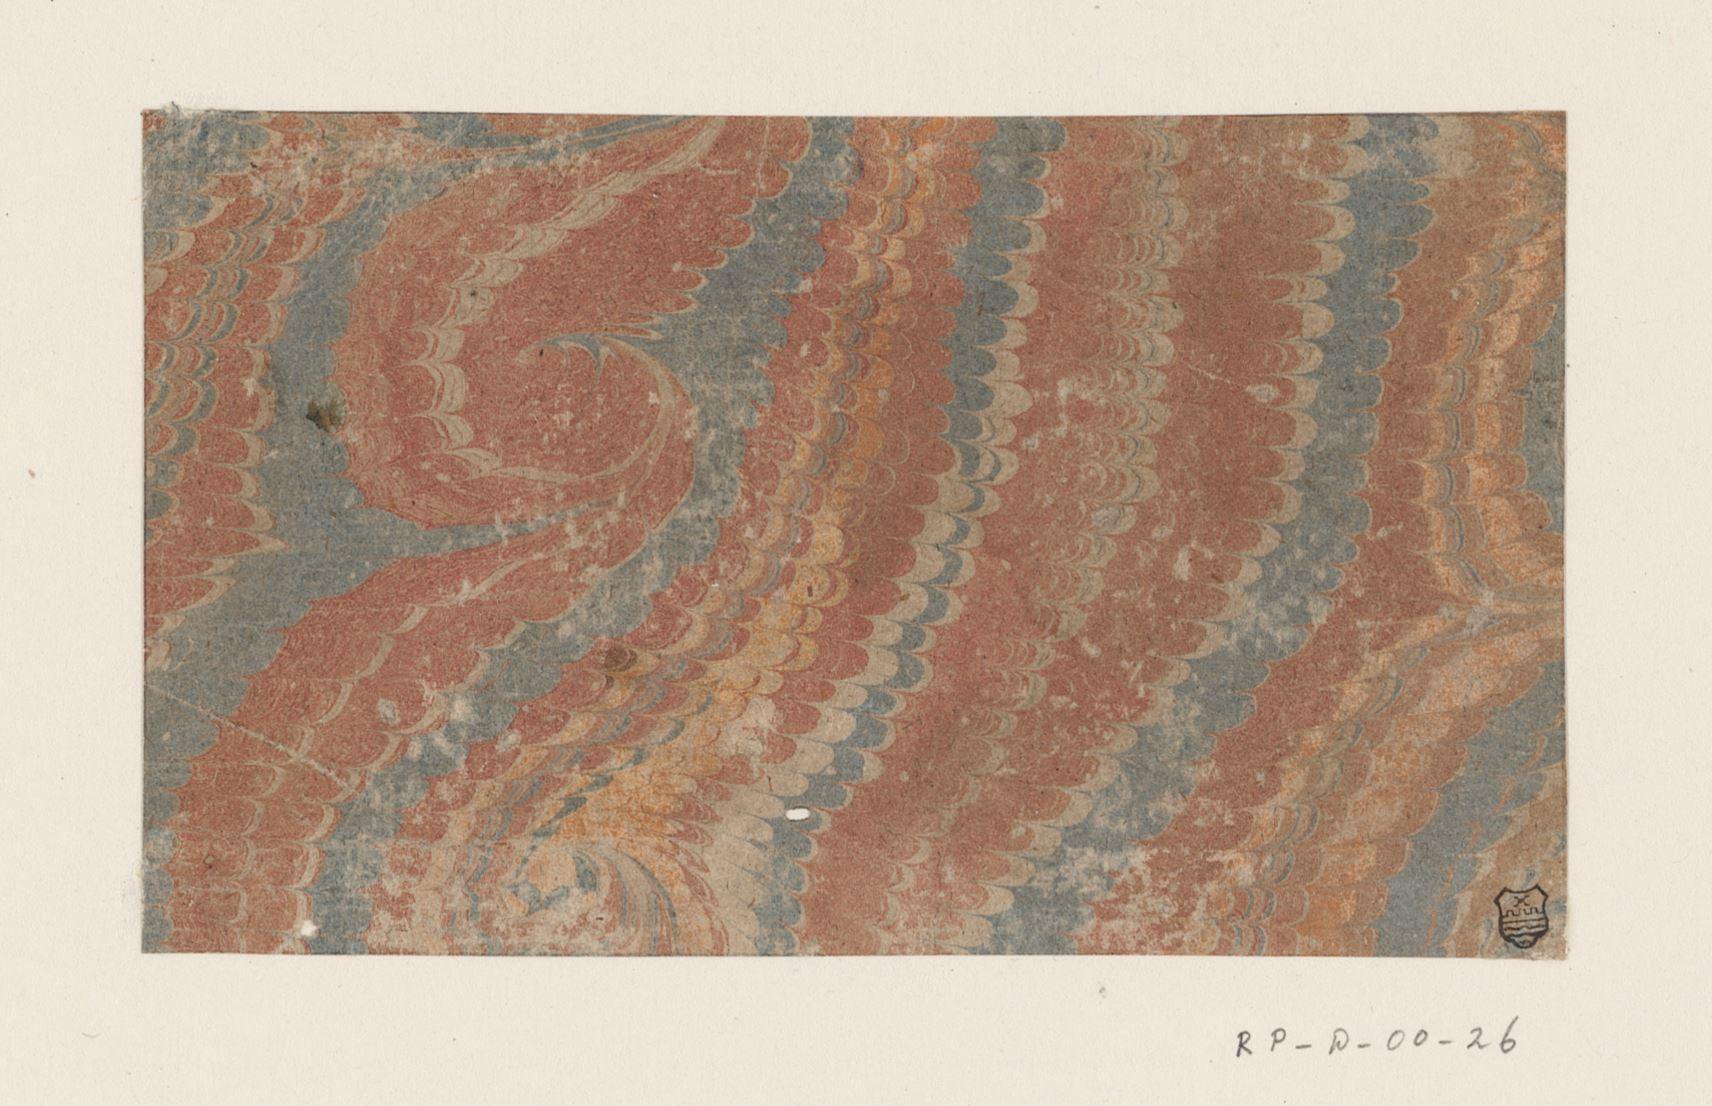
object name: marbled paper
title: Spiraalkammarmer in rood, geel, en blauw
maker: Anonymous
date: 1700-1850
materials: paint, paper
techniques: marbled paper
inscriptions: collector's mark: Lugt 2760